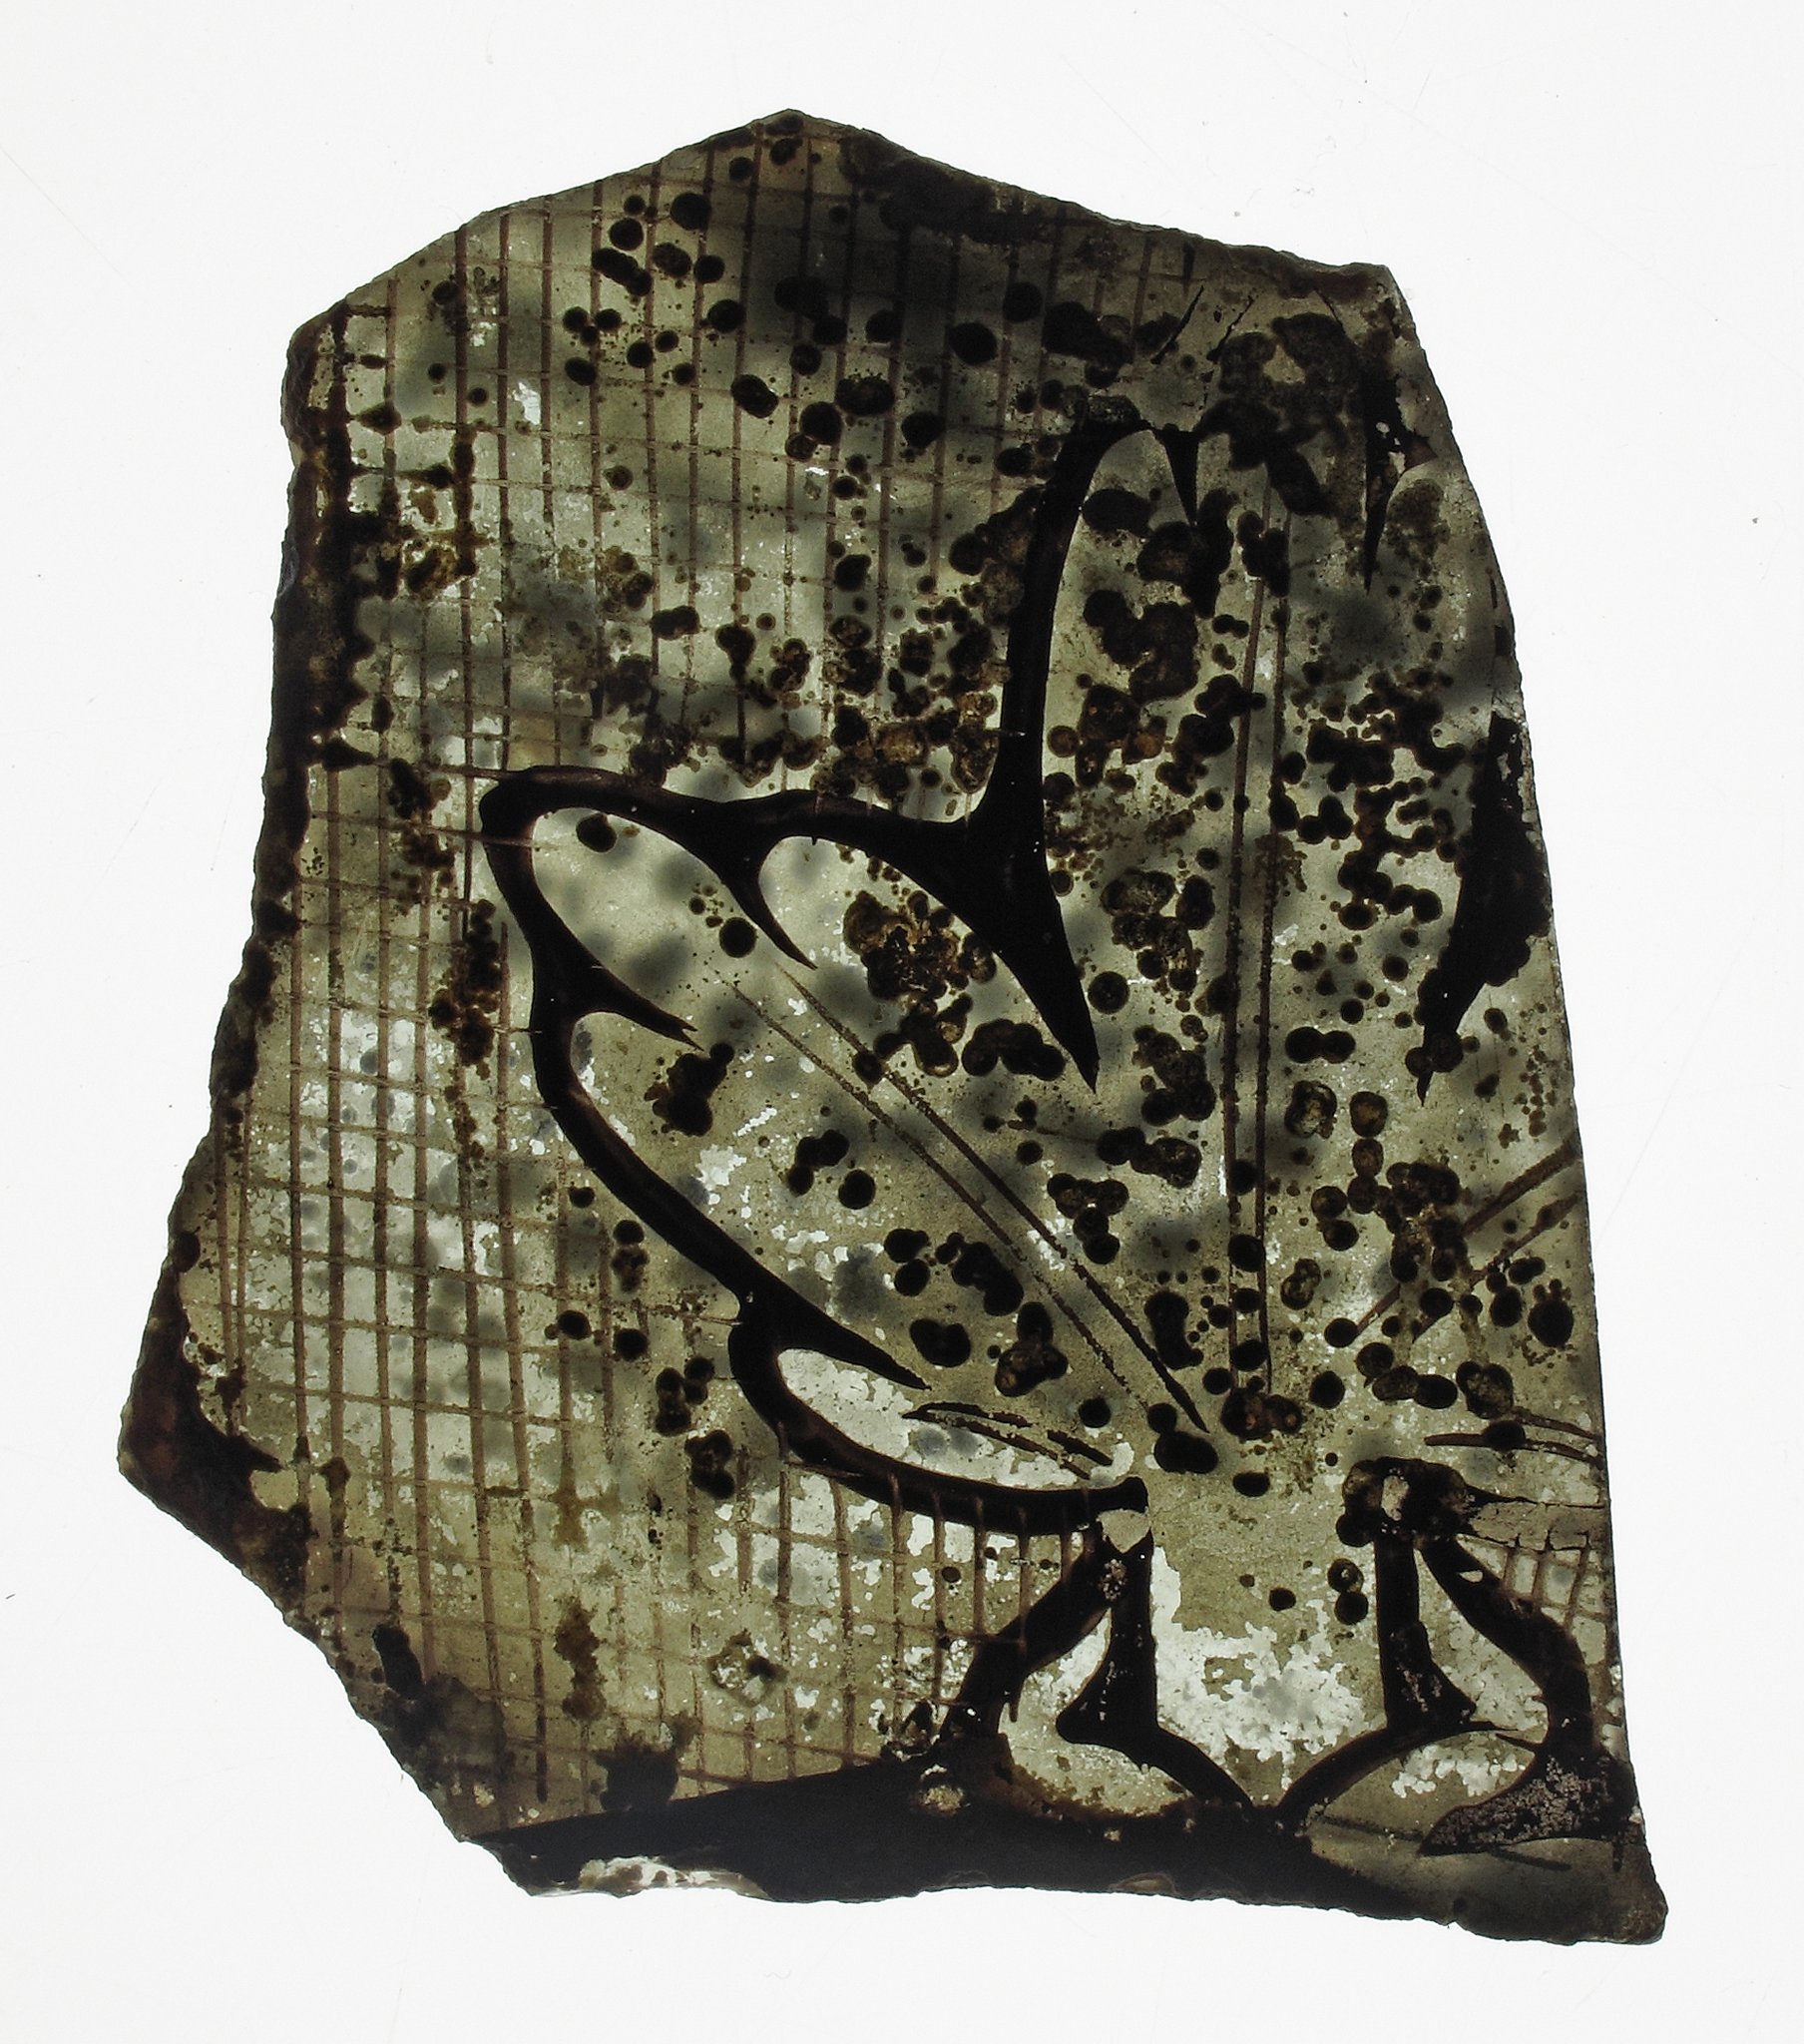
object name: fragment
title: Glass Fragment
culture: french or british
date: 1301-1333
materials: glass